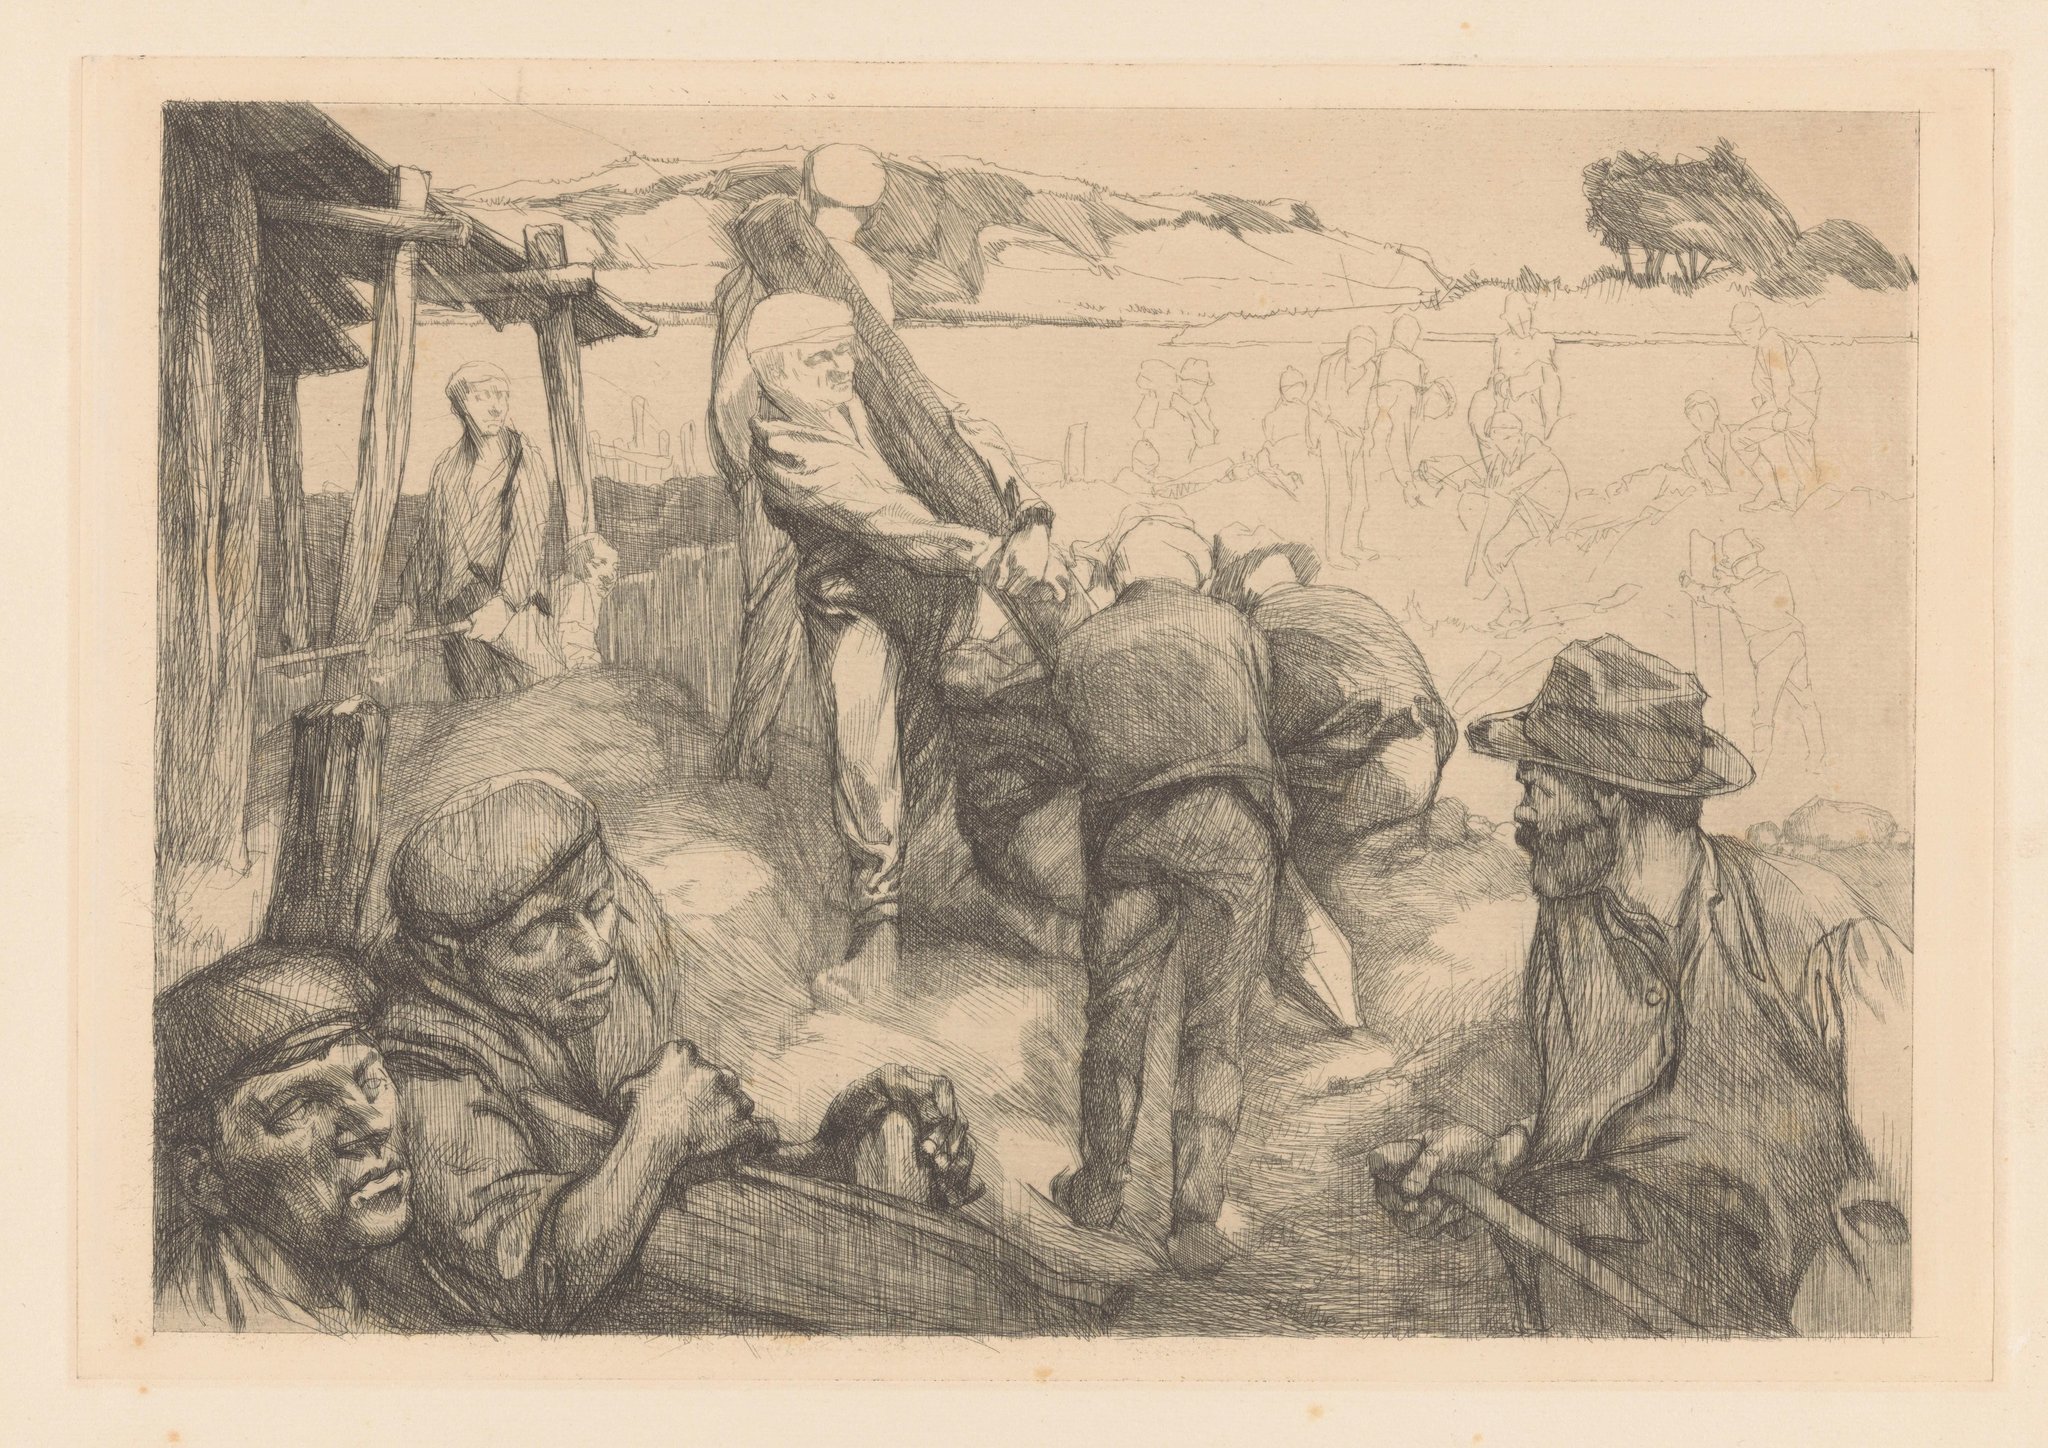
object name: print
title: Bouwarbeiders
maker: johannes josephus aarts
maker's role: draughtsman, print maker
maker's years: 1871-1934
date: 1881-1934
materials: paper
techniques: etching, intaglio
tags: ramming, driving piles (~ building activities), working class, labourers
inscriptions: collector's mark: Lugt 2228, collector's mark: Lugt 2760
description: Een groep arbeiders plaatst een houten paal in de grond. Links op de voorgrond leunt een man tegen een balk. Rechts op de voorgrond een man met een schep.